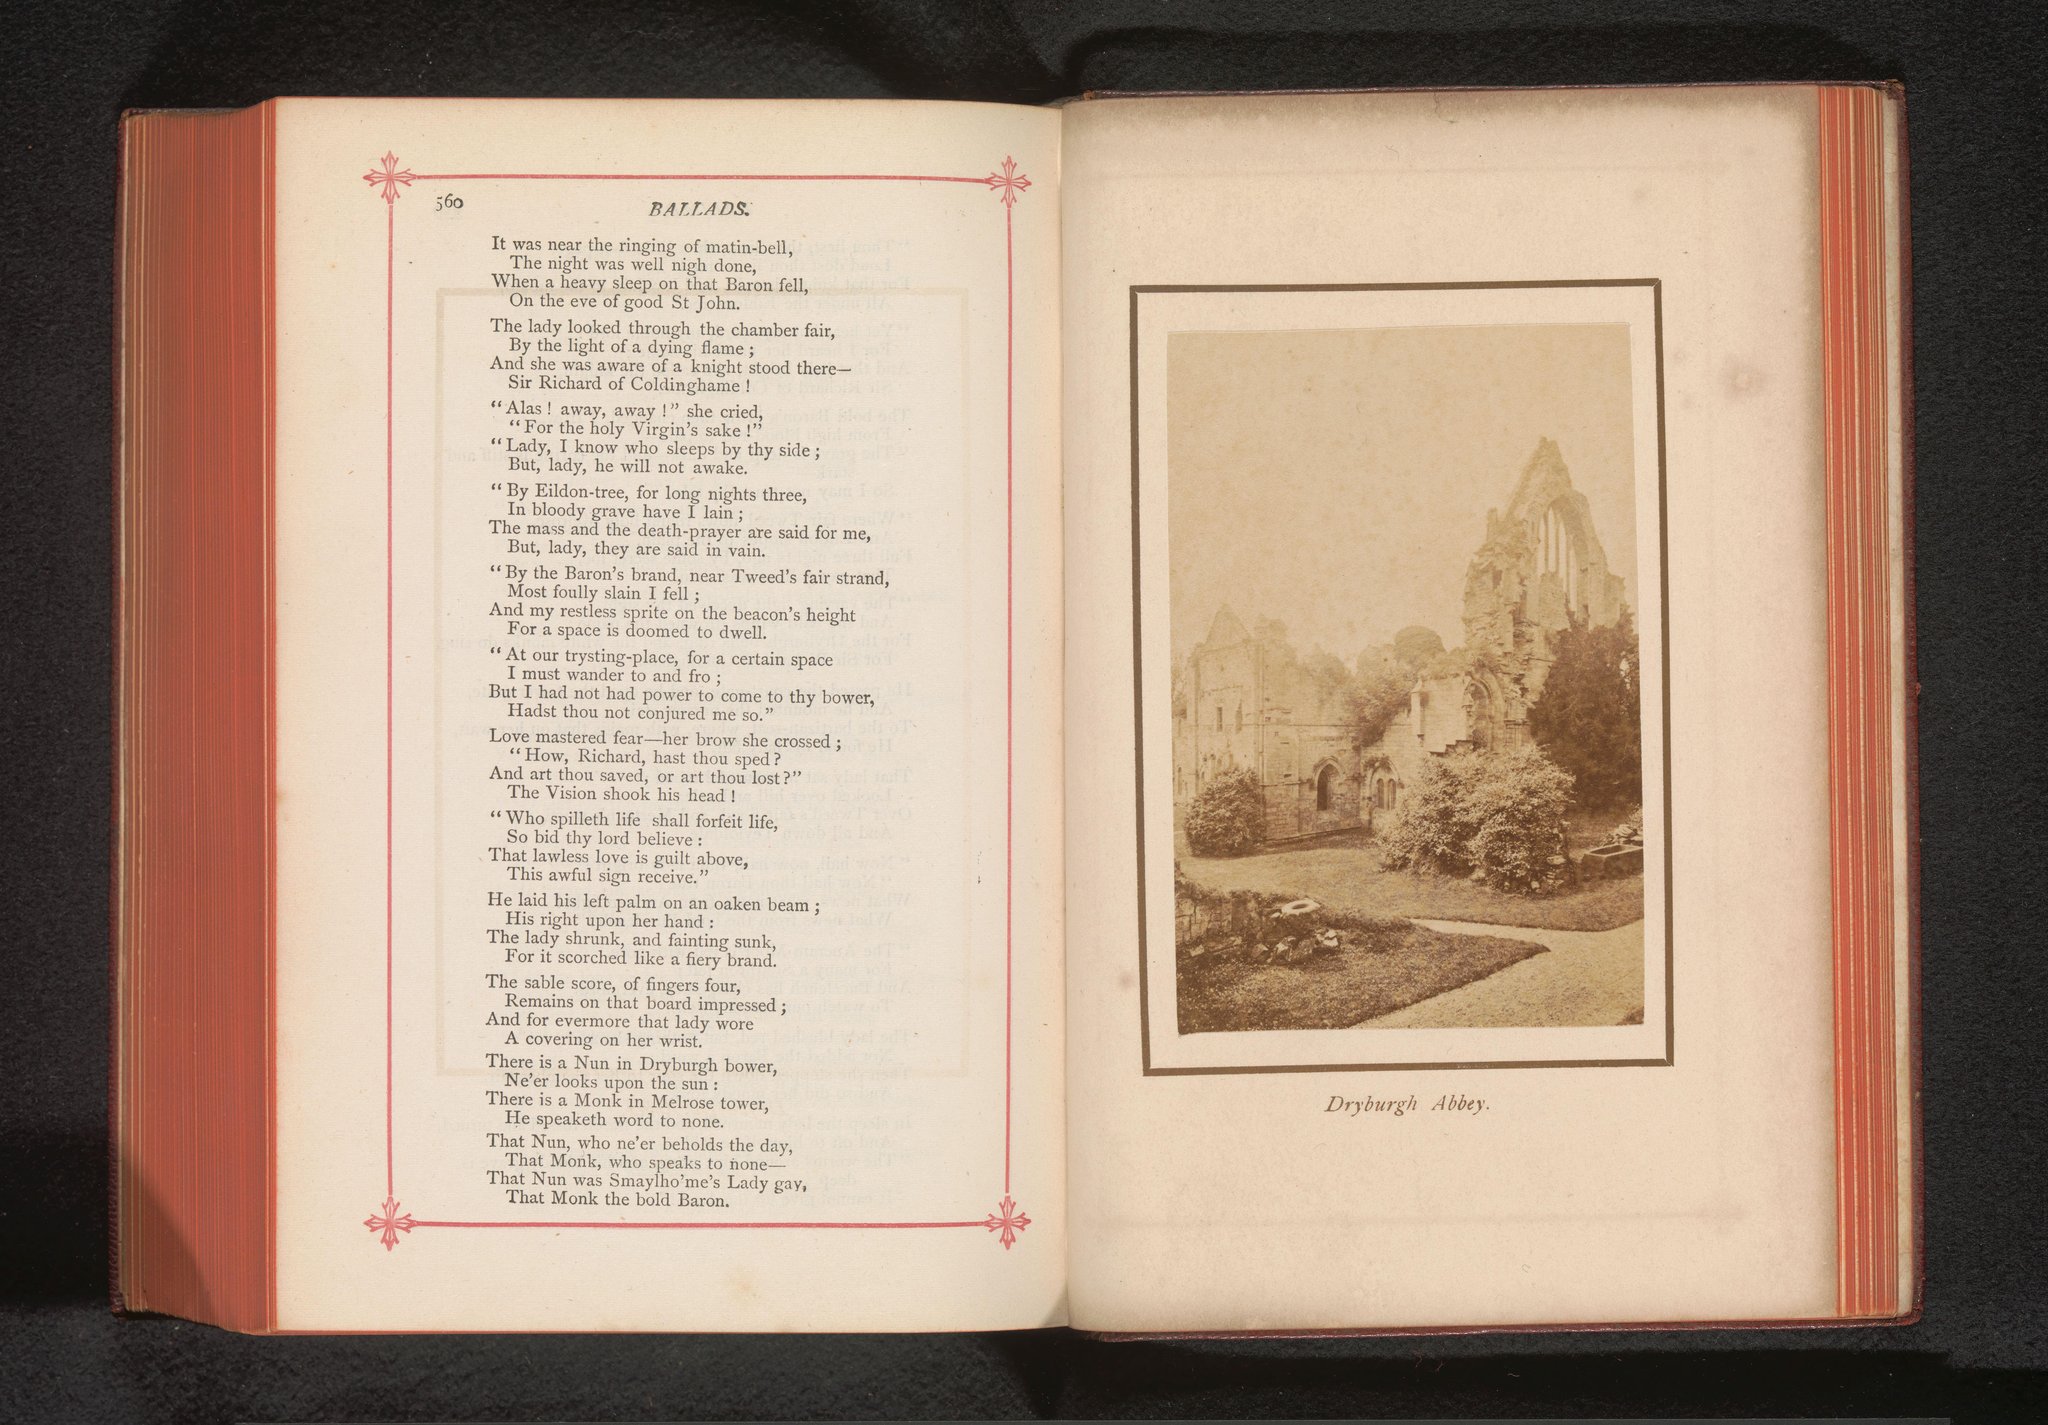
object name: photograph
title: Dryburgh Abbey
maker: george washington wilson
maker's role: publisher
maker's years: 1823-1893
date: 1885-1890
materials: photographic support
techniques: albumen print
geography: scotland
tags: ruin of church, monastery, etc.